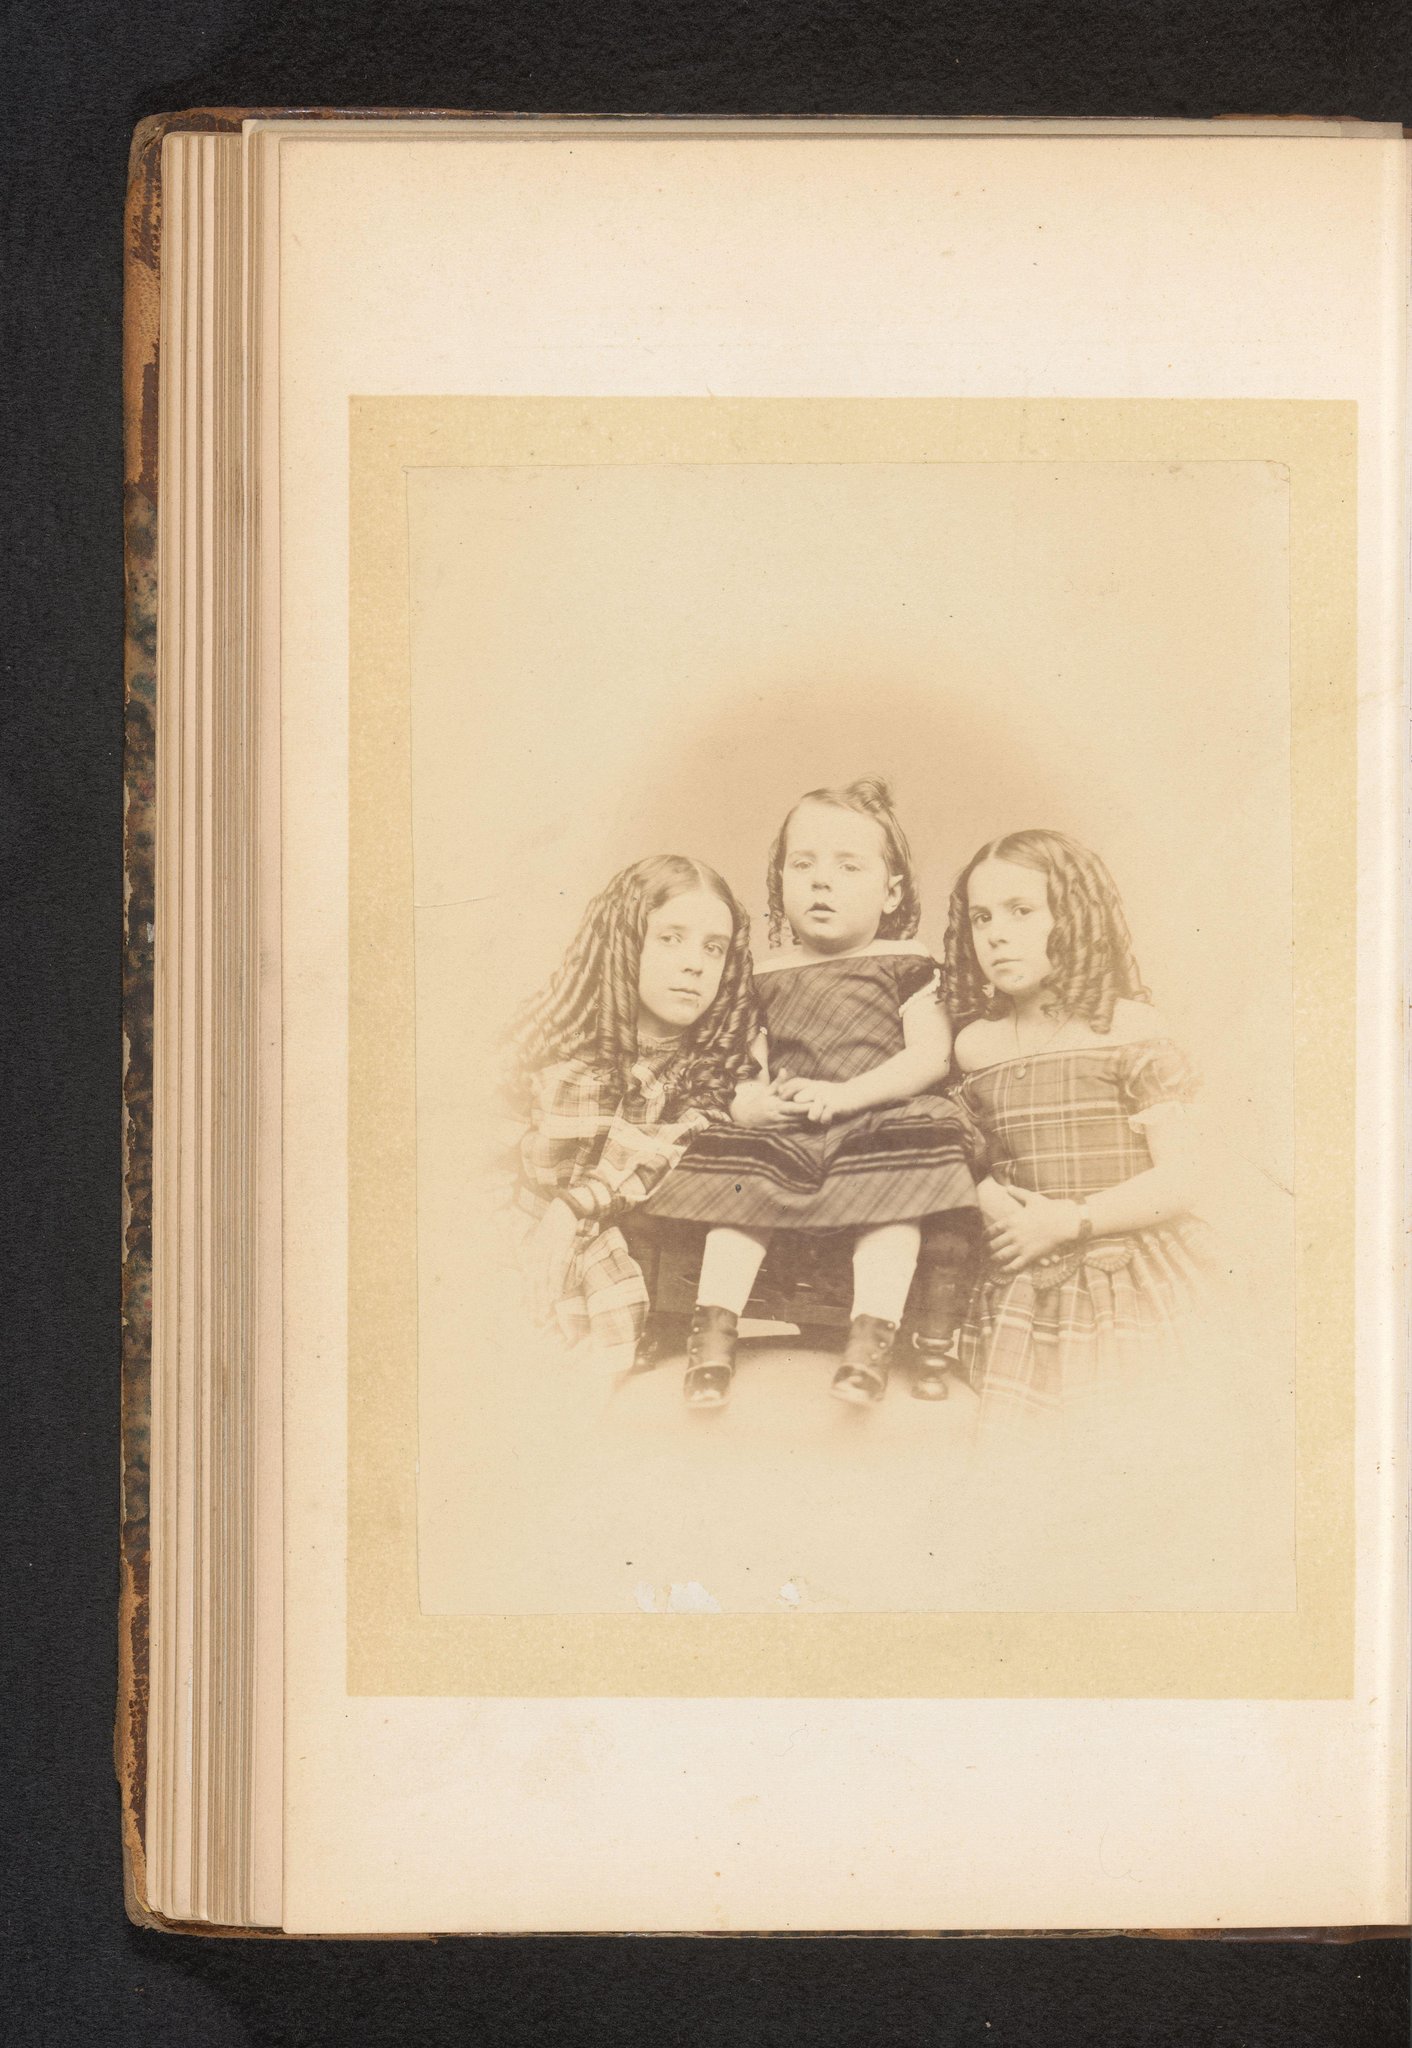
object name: photograph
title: Portret van drie onbekende jonge meisjes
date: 1861-1866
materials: photographic support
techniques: albumen print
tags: historical persons not known by name - bb - woman, girl (child between toddler and youth), toddler (female)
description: Foto tegenover pagina 161, achter semi-transparante omslag.